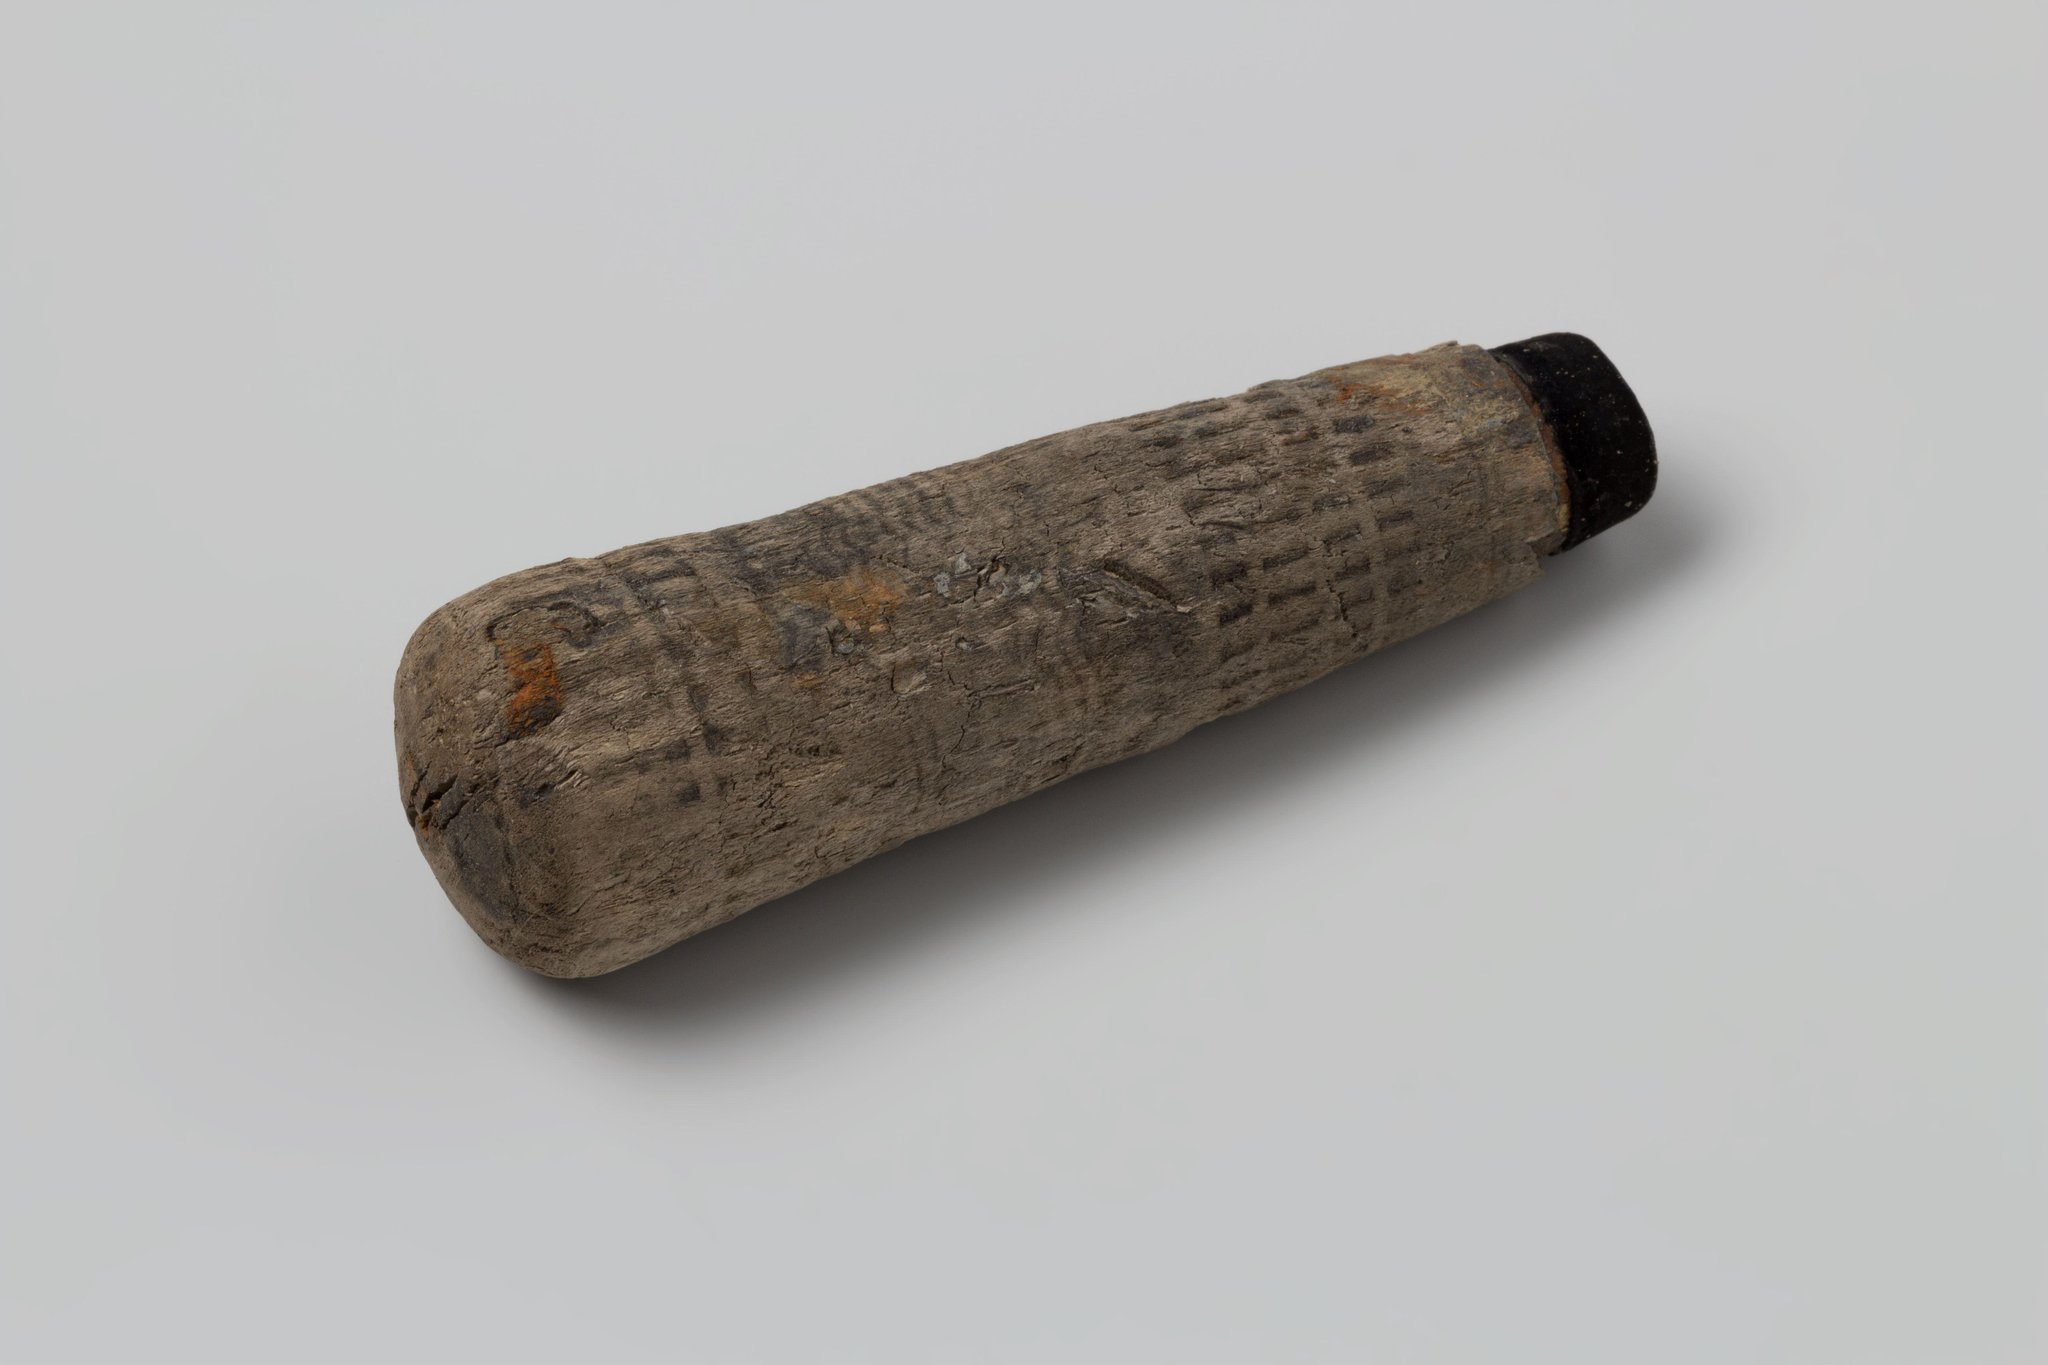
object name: knife handle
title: Messenheft uit het wrak van de Oost-Indiëvaarder Hollandia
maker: Anonymous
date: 1700-1743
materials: copper, wood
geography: netherlands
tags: verenigde oostindische compagnie, hollandia (schip), annet